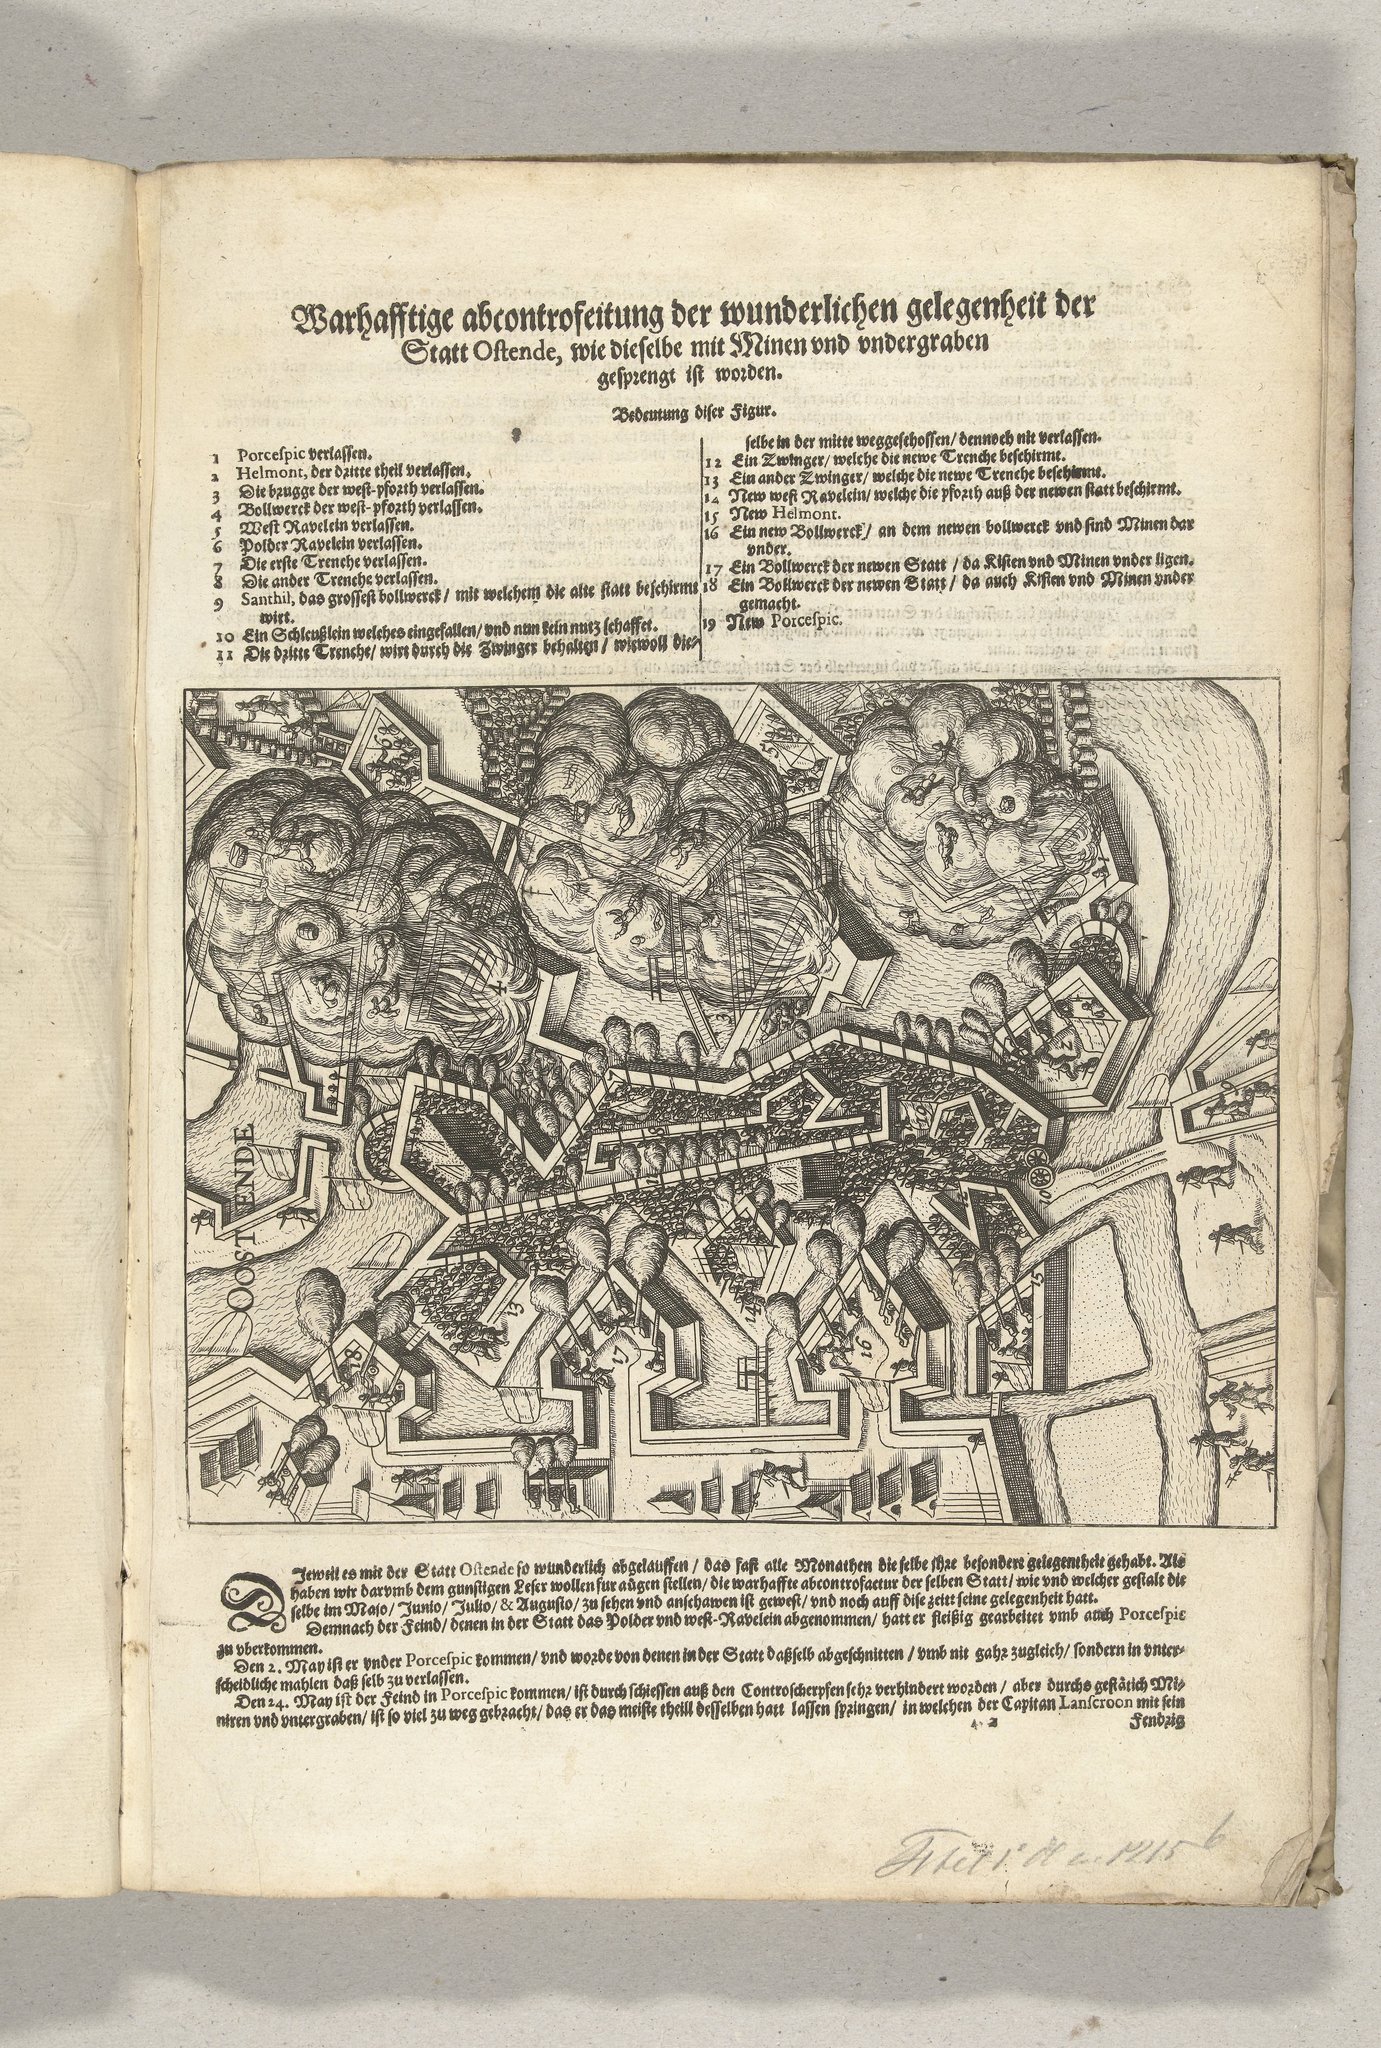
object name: print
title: Warhafftige abcontrofeitung der wunderlichen gelegenheit der Statt Ostende, wie dieselbe mit Minen und undergraben gesprengt ist worden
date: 1604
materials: paper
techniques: etching, letterpress printing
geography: low countries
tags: siege, position war, projectiles, explosives, etc.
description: Onderdeel van illustraties in: Belaegerung der Statt Ostende : Journal: Tagregister... aller gedenckwurdigsten Sachen... so inner und ausserhalb... sich zugetragen... von 5 July 1601. biss auff diese.. Herbstmisse Anno 1604... auss der Niderlendischen in die Hochteutsche Sprach transferirt, Und mit: Journal. Ander theil uber die Belägerung der statt Ostende biss auf die Herbstmiss in Sept. 1604 bey gefugt Mappa der Statt Ostende neben dem abriss des Parvae und Novae Troiae, s.l., 1604, fol°, ill. Hierbij gevoegd enkele prenten voorzien van Duitse teksten, 1604 (z.n., z.p.). In het exemplaar in de collectie van de Rijksmuseum Research Library (326 F 10).